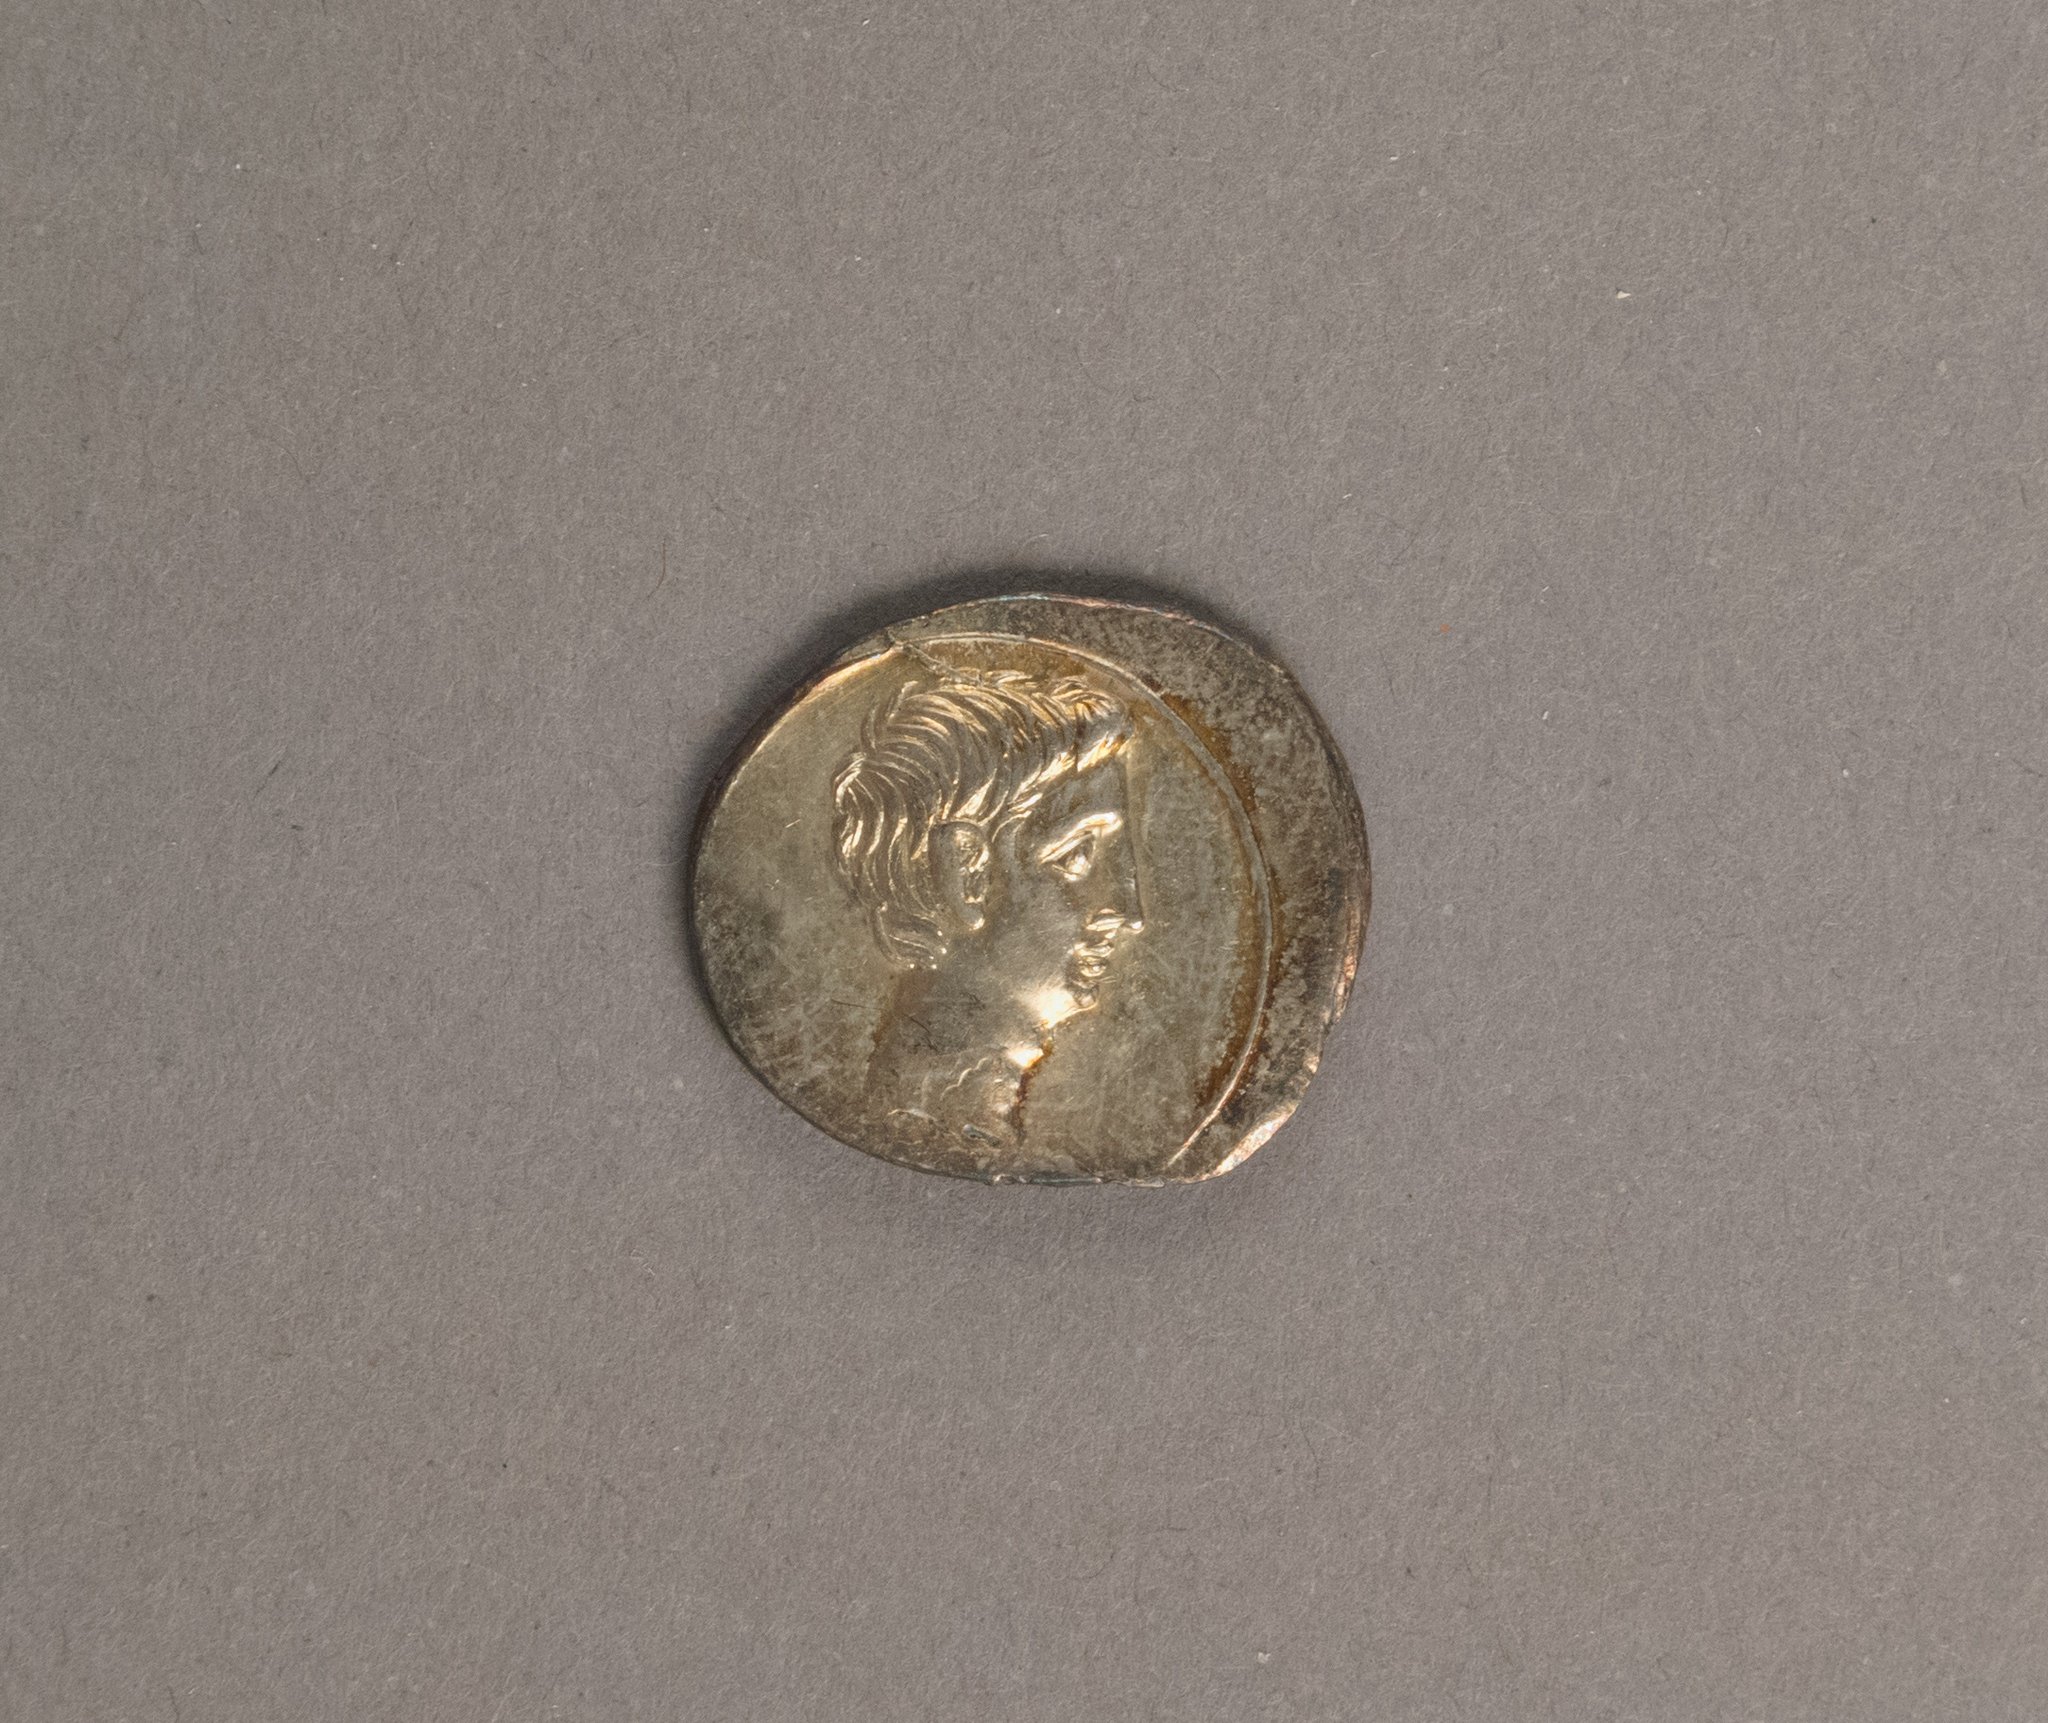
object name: denarius of octavian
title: Silver denarius of Octavian (Augustus)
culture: roman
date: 29-27 BCE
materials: silver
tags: emperor augustus,profiles